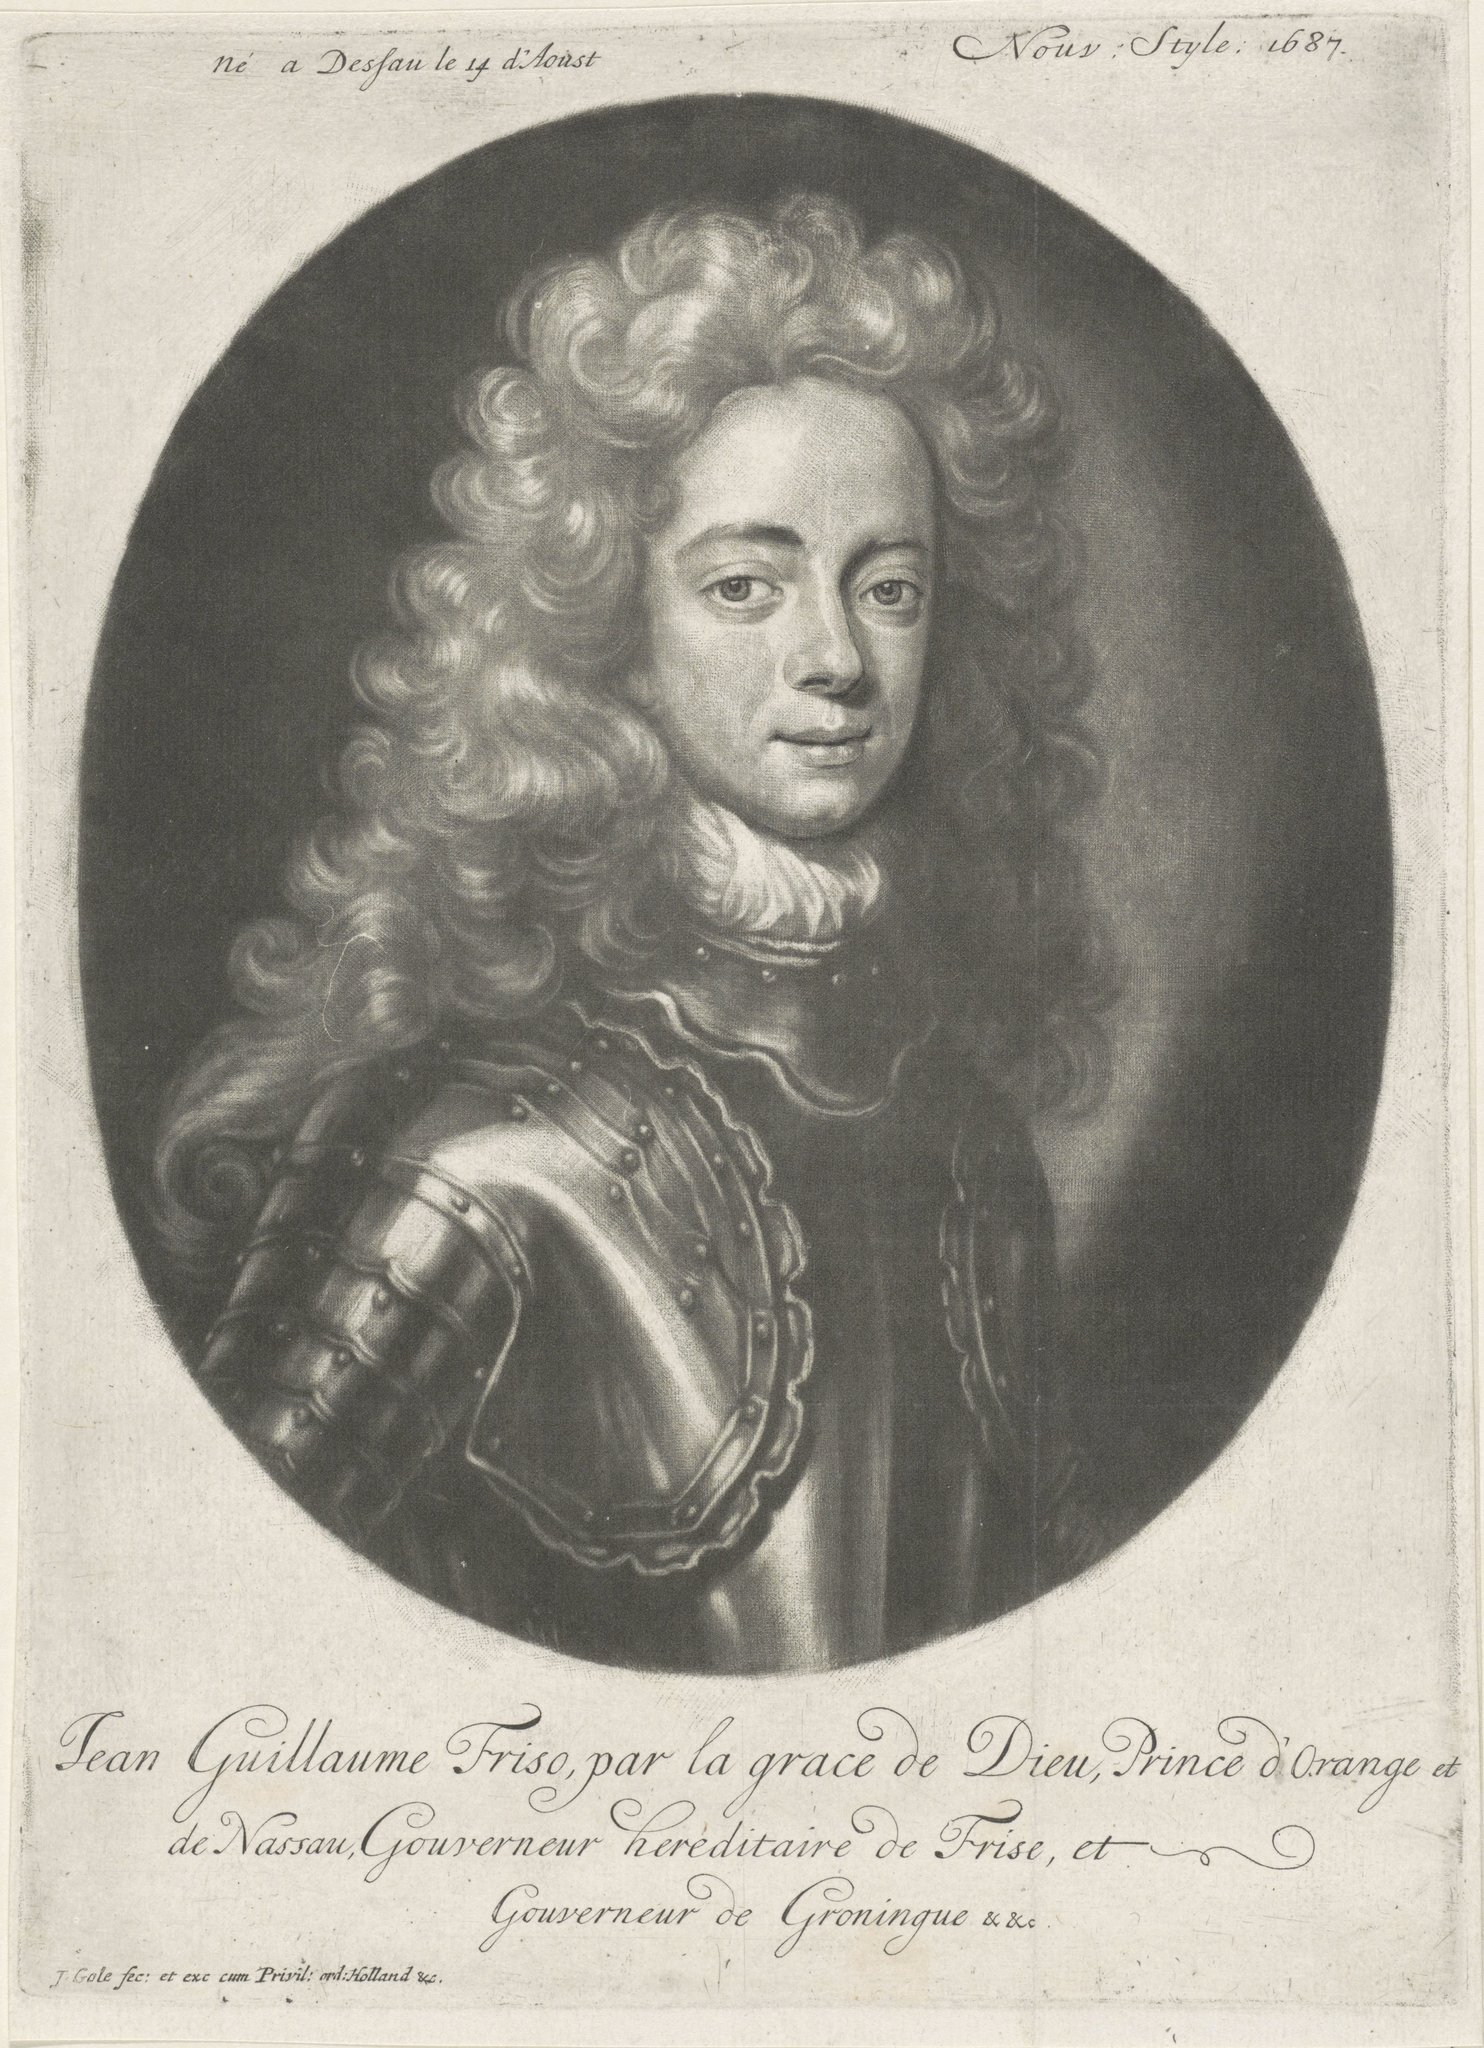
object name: print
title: Portret van Johan Willem Friso, prins van Oranje-Nassau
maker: jacob gole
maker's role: print maker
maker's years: 1660-1724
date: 1705-1724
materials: paper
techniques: engraving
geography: amsterdam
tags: johan willem friso (prins van oranje-nassau)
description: De hier vermelde titel verwijst naar de hoogst verkregen titel van de geportretteerde, niet per se naar de titel die de geportretteerde op deze voorstelling draagt.